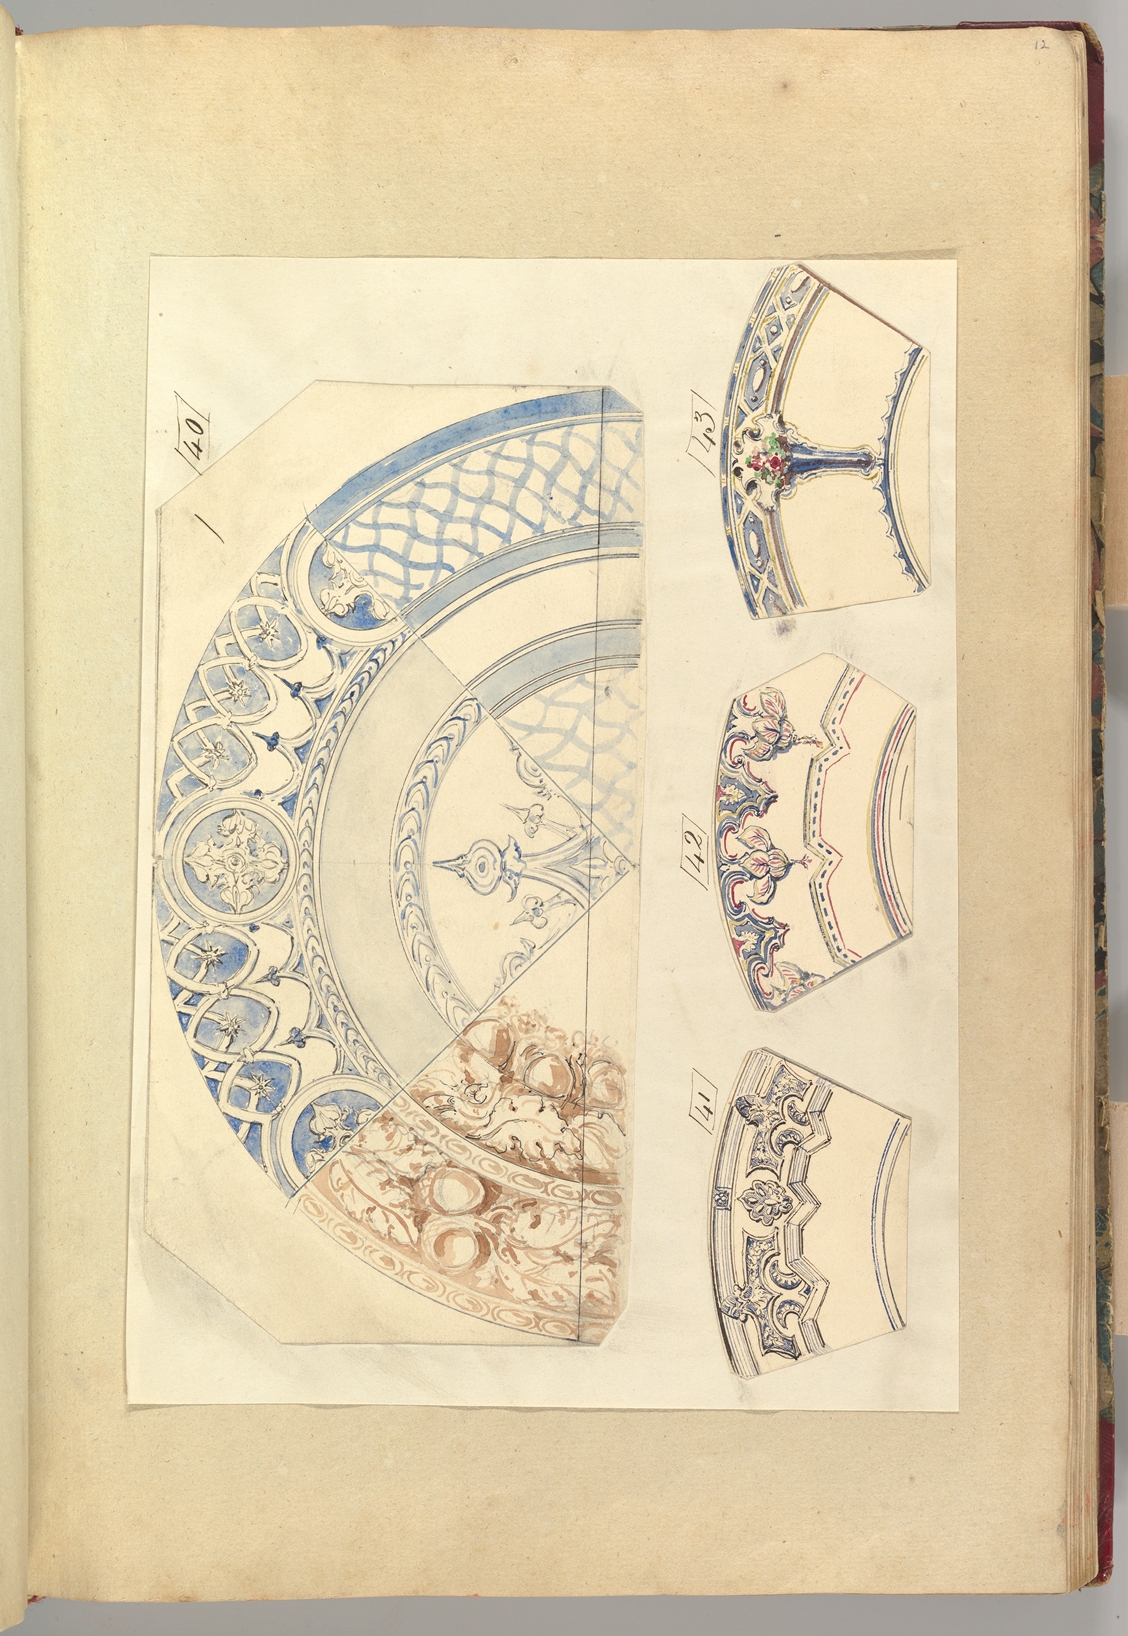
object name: drawing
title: Six Designs for Decorated Plates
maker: alfred henry forrester [alfred crowquill]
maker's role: artist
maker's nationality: british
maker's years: 1804-1872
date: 1845-1855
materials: ink, watercolor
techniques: pen